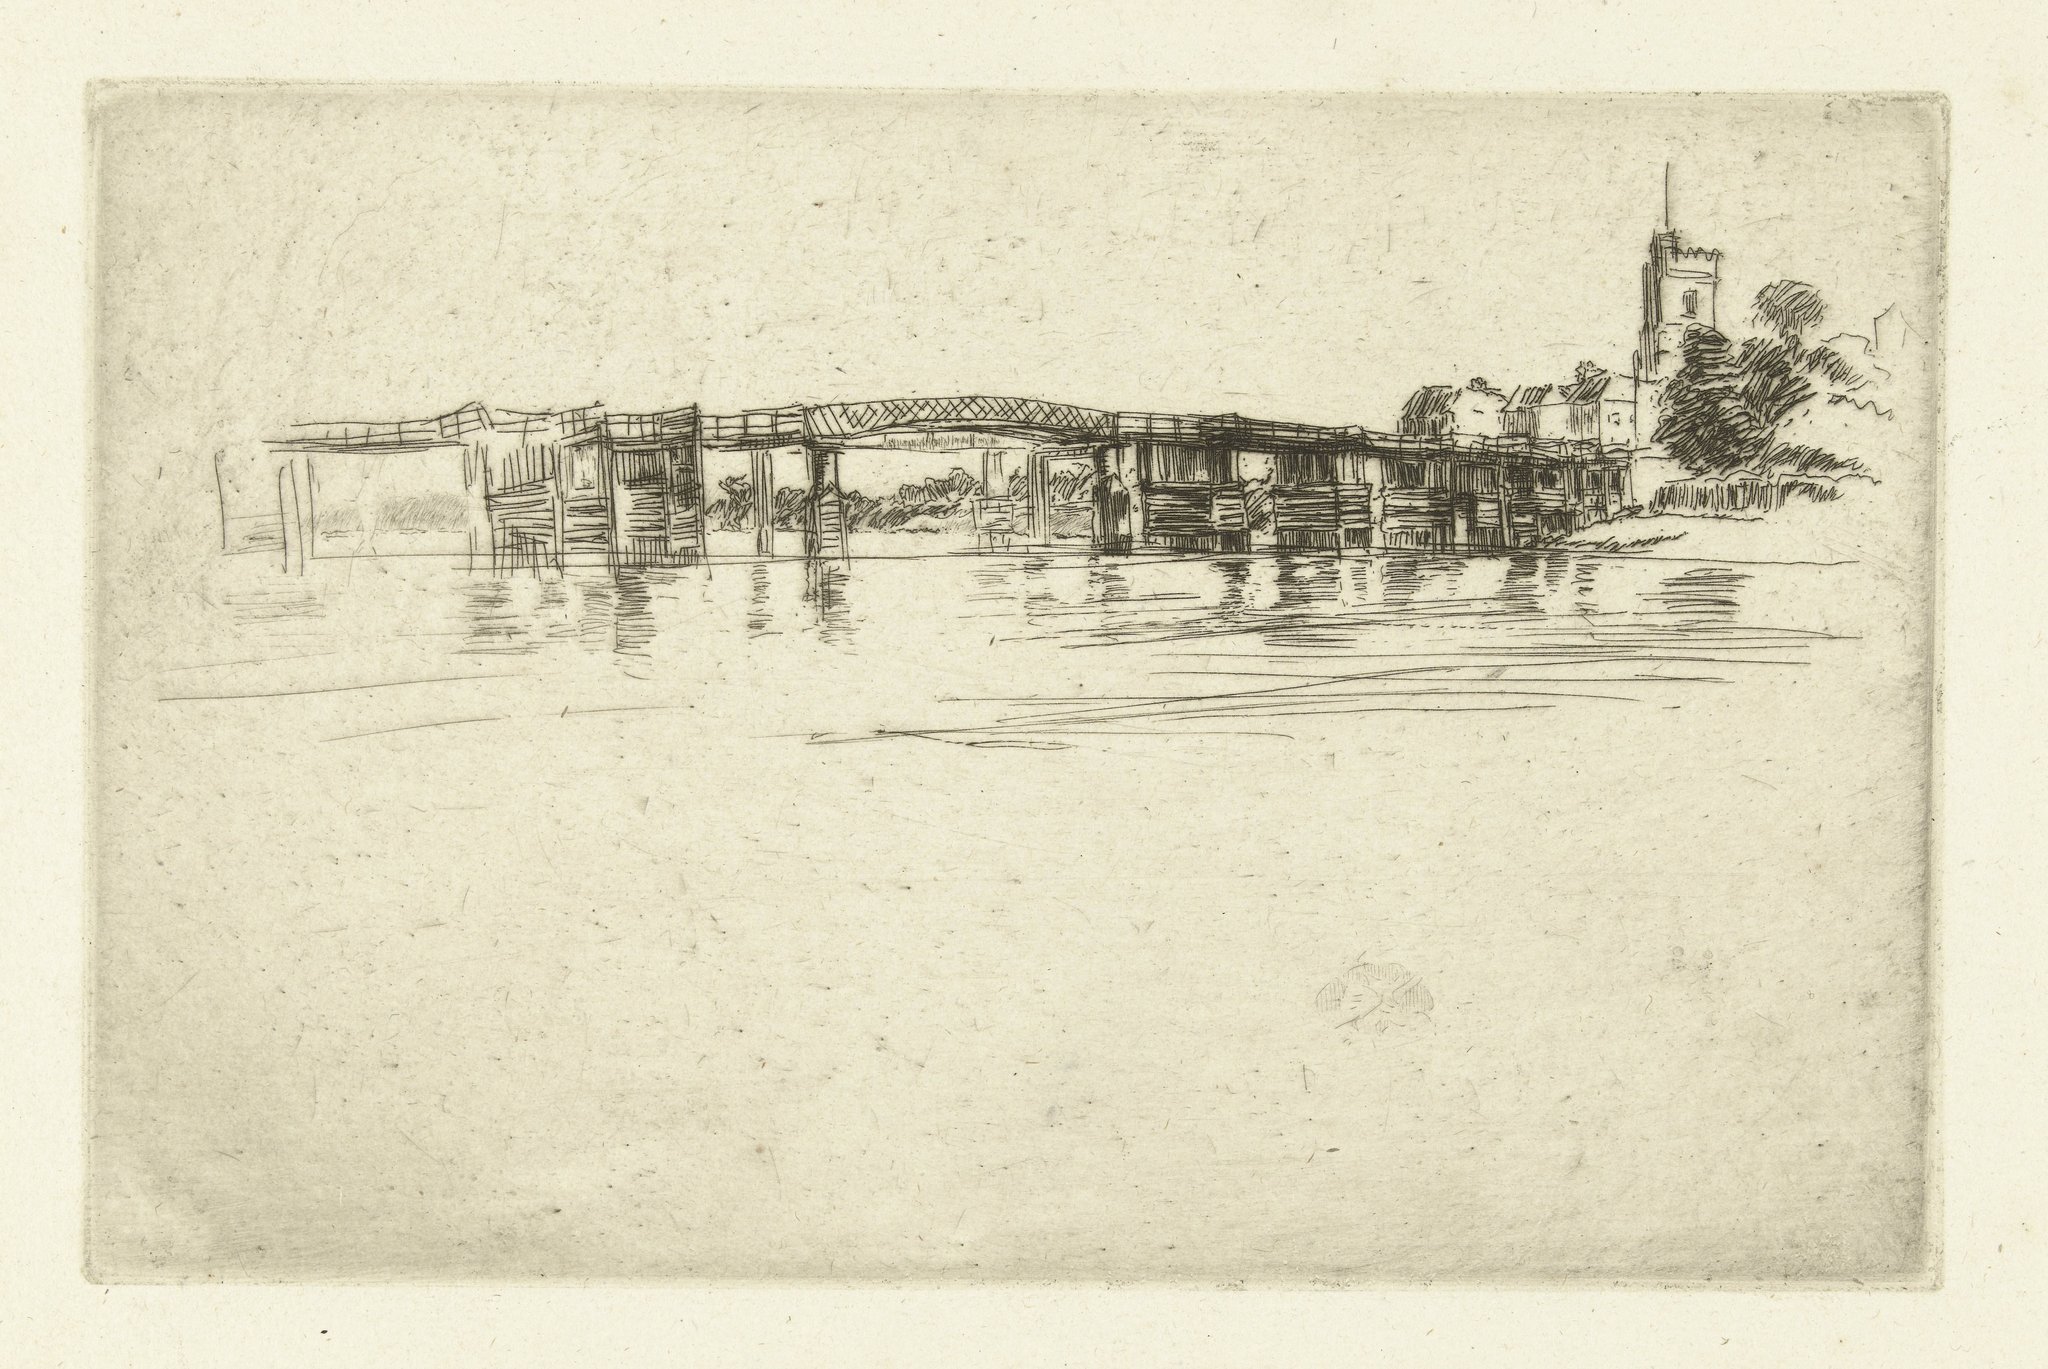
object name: print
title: The Little Putney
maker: james abbott mcneill whistler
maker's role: painter, print maker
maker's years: 1834-1903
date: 1879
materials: paper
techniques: drypoint, etching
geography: england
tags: bridge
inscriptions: collector's mark: Lugt 2166, collector's mark: Lugt 2760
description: Brug over de rivier de Theems, op de rechter oever een kerk.